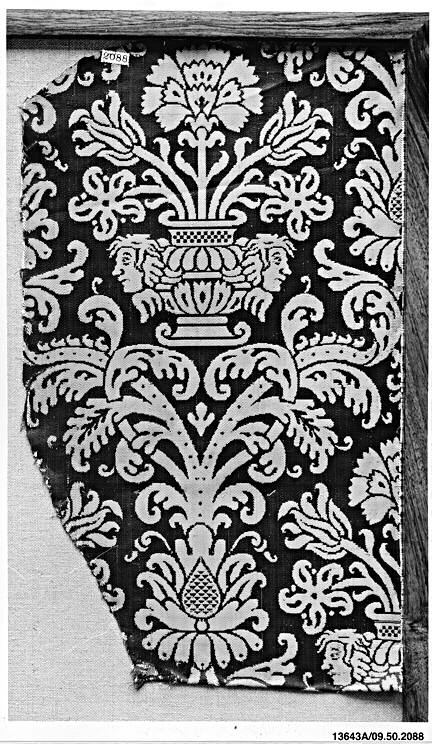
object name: piece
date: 1567-1633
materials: silk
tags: faces,flowers